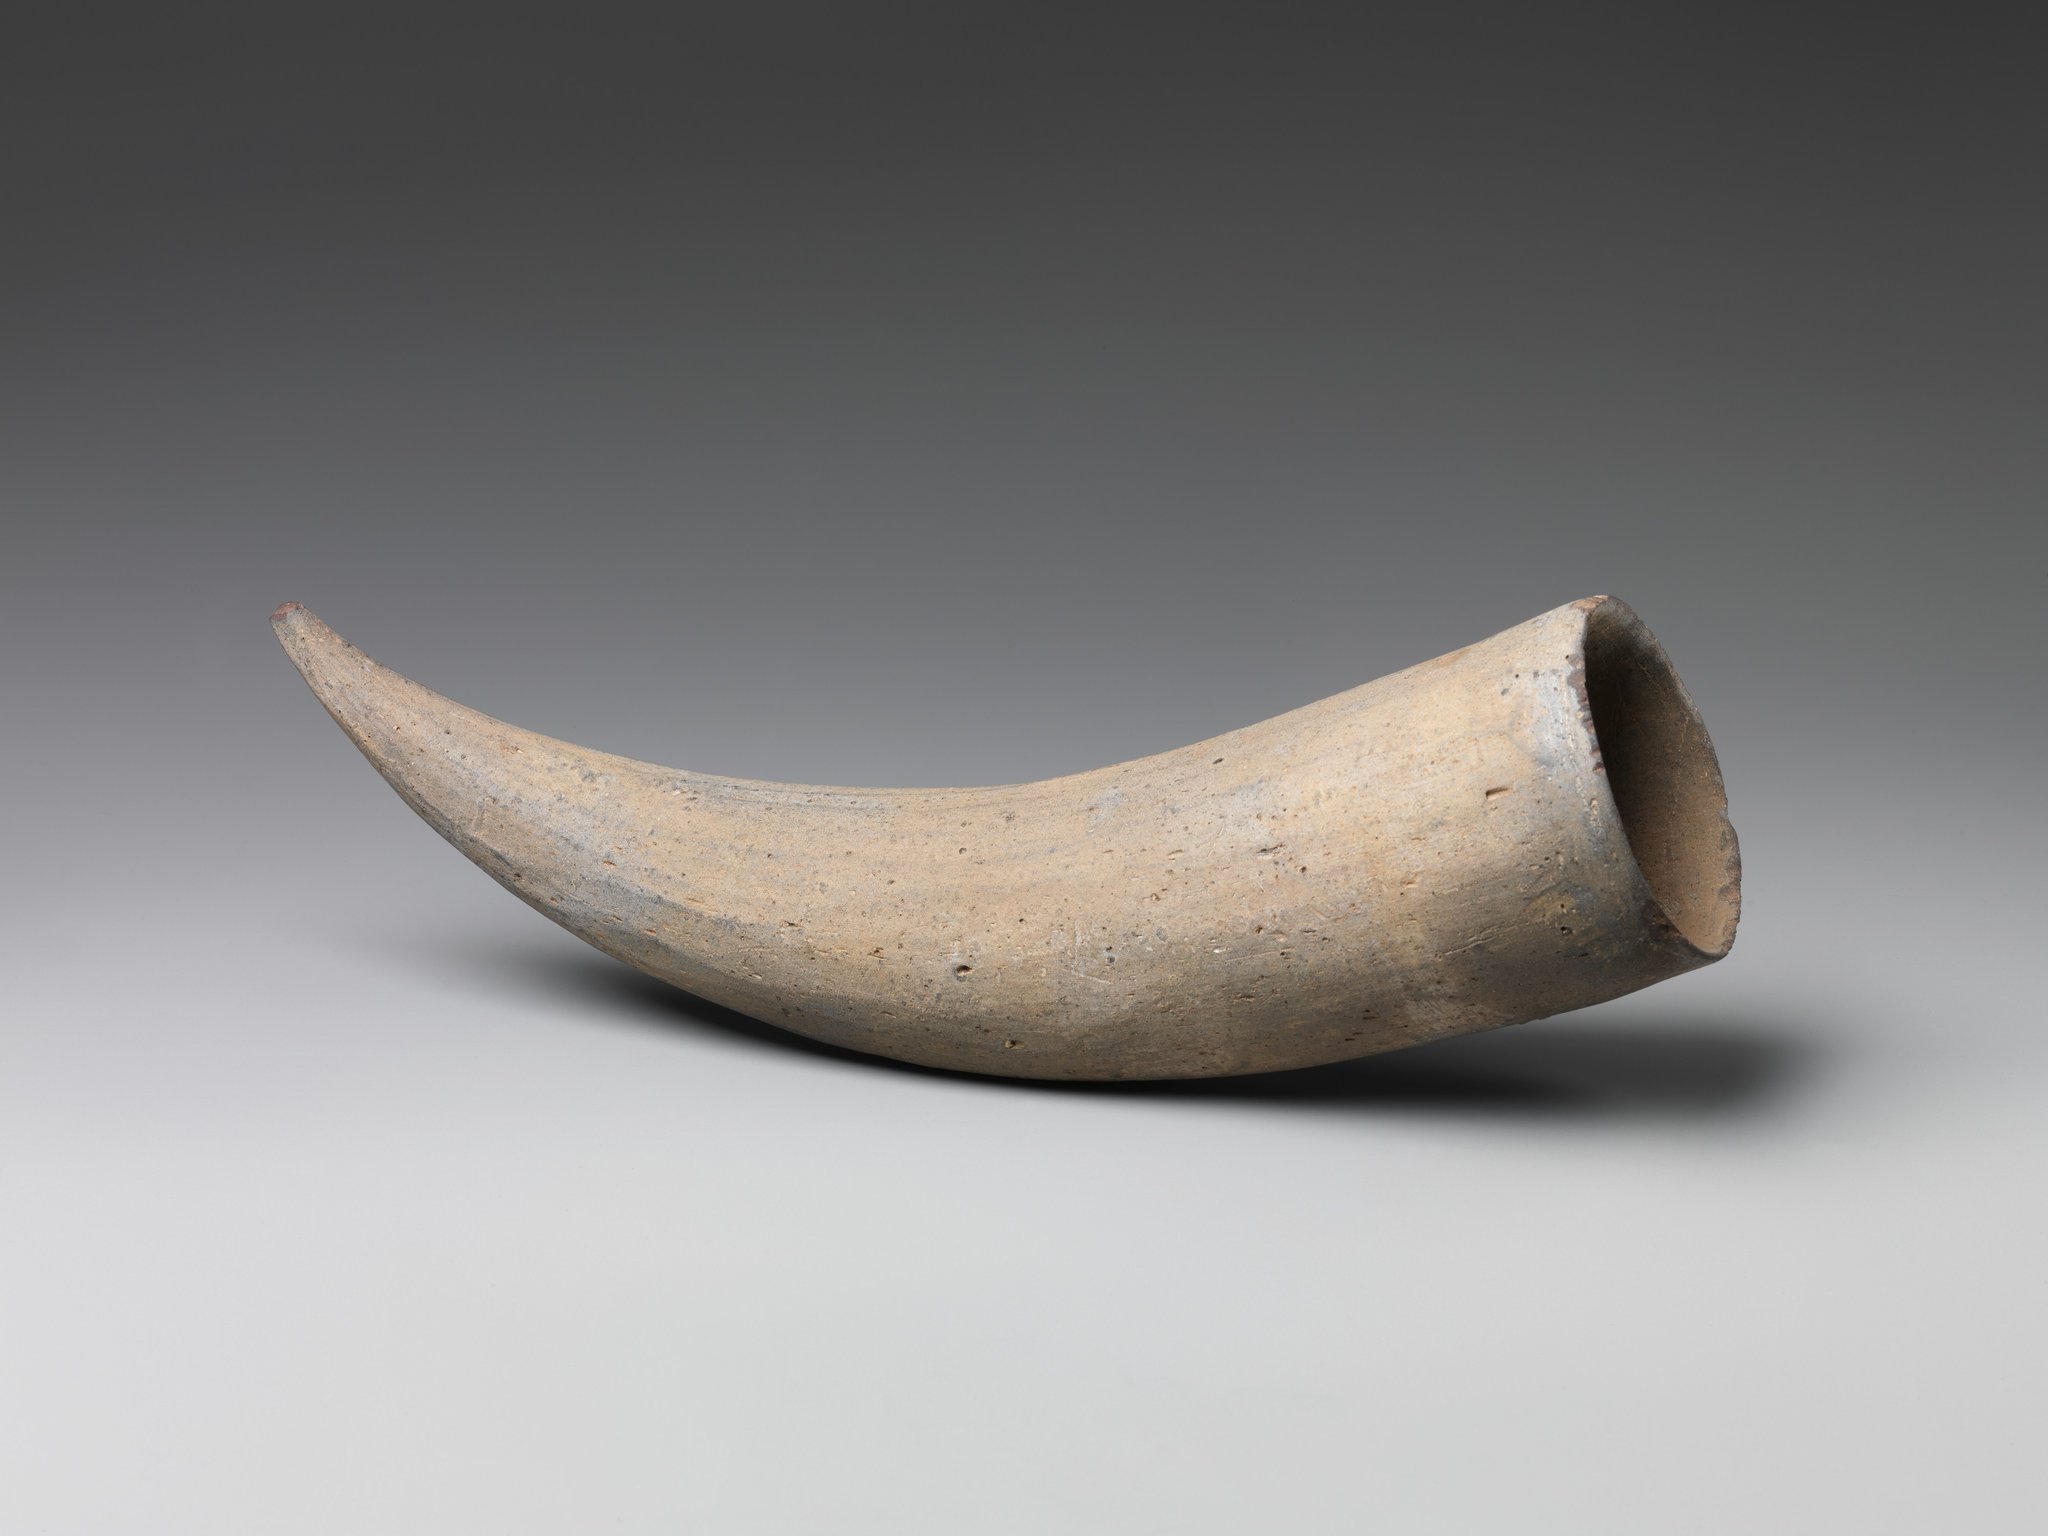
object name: drinking cup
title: Horn-shaped drinking cup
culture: korean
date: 401-500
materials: stoneware